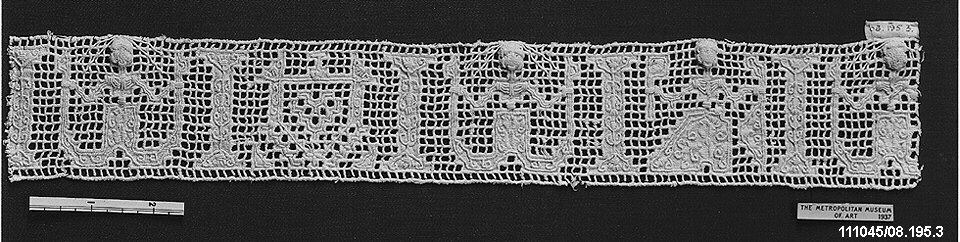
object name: band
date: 1601-1700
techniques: embroidery